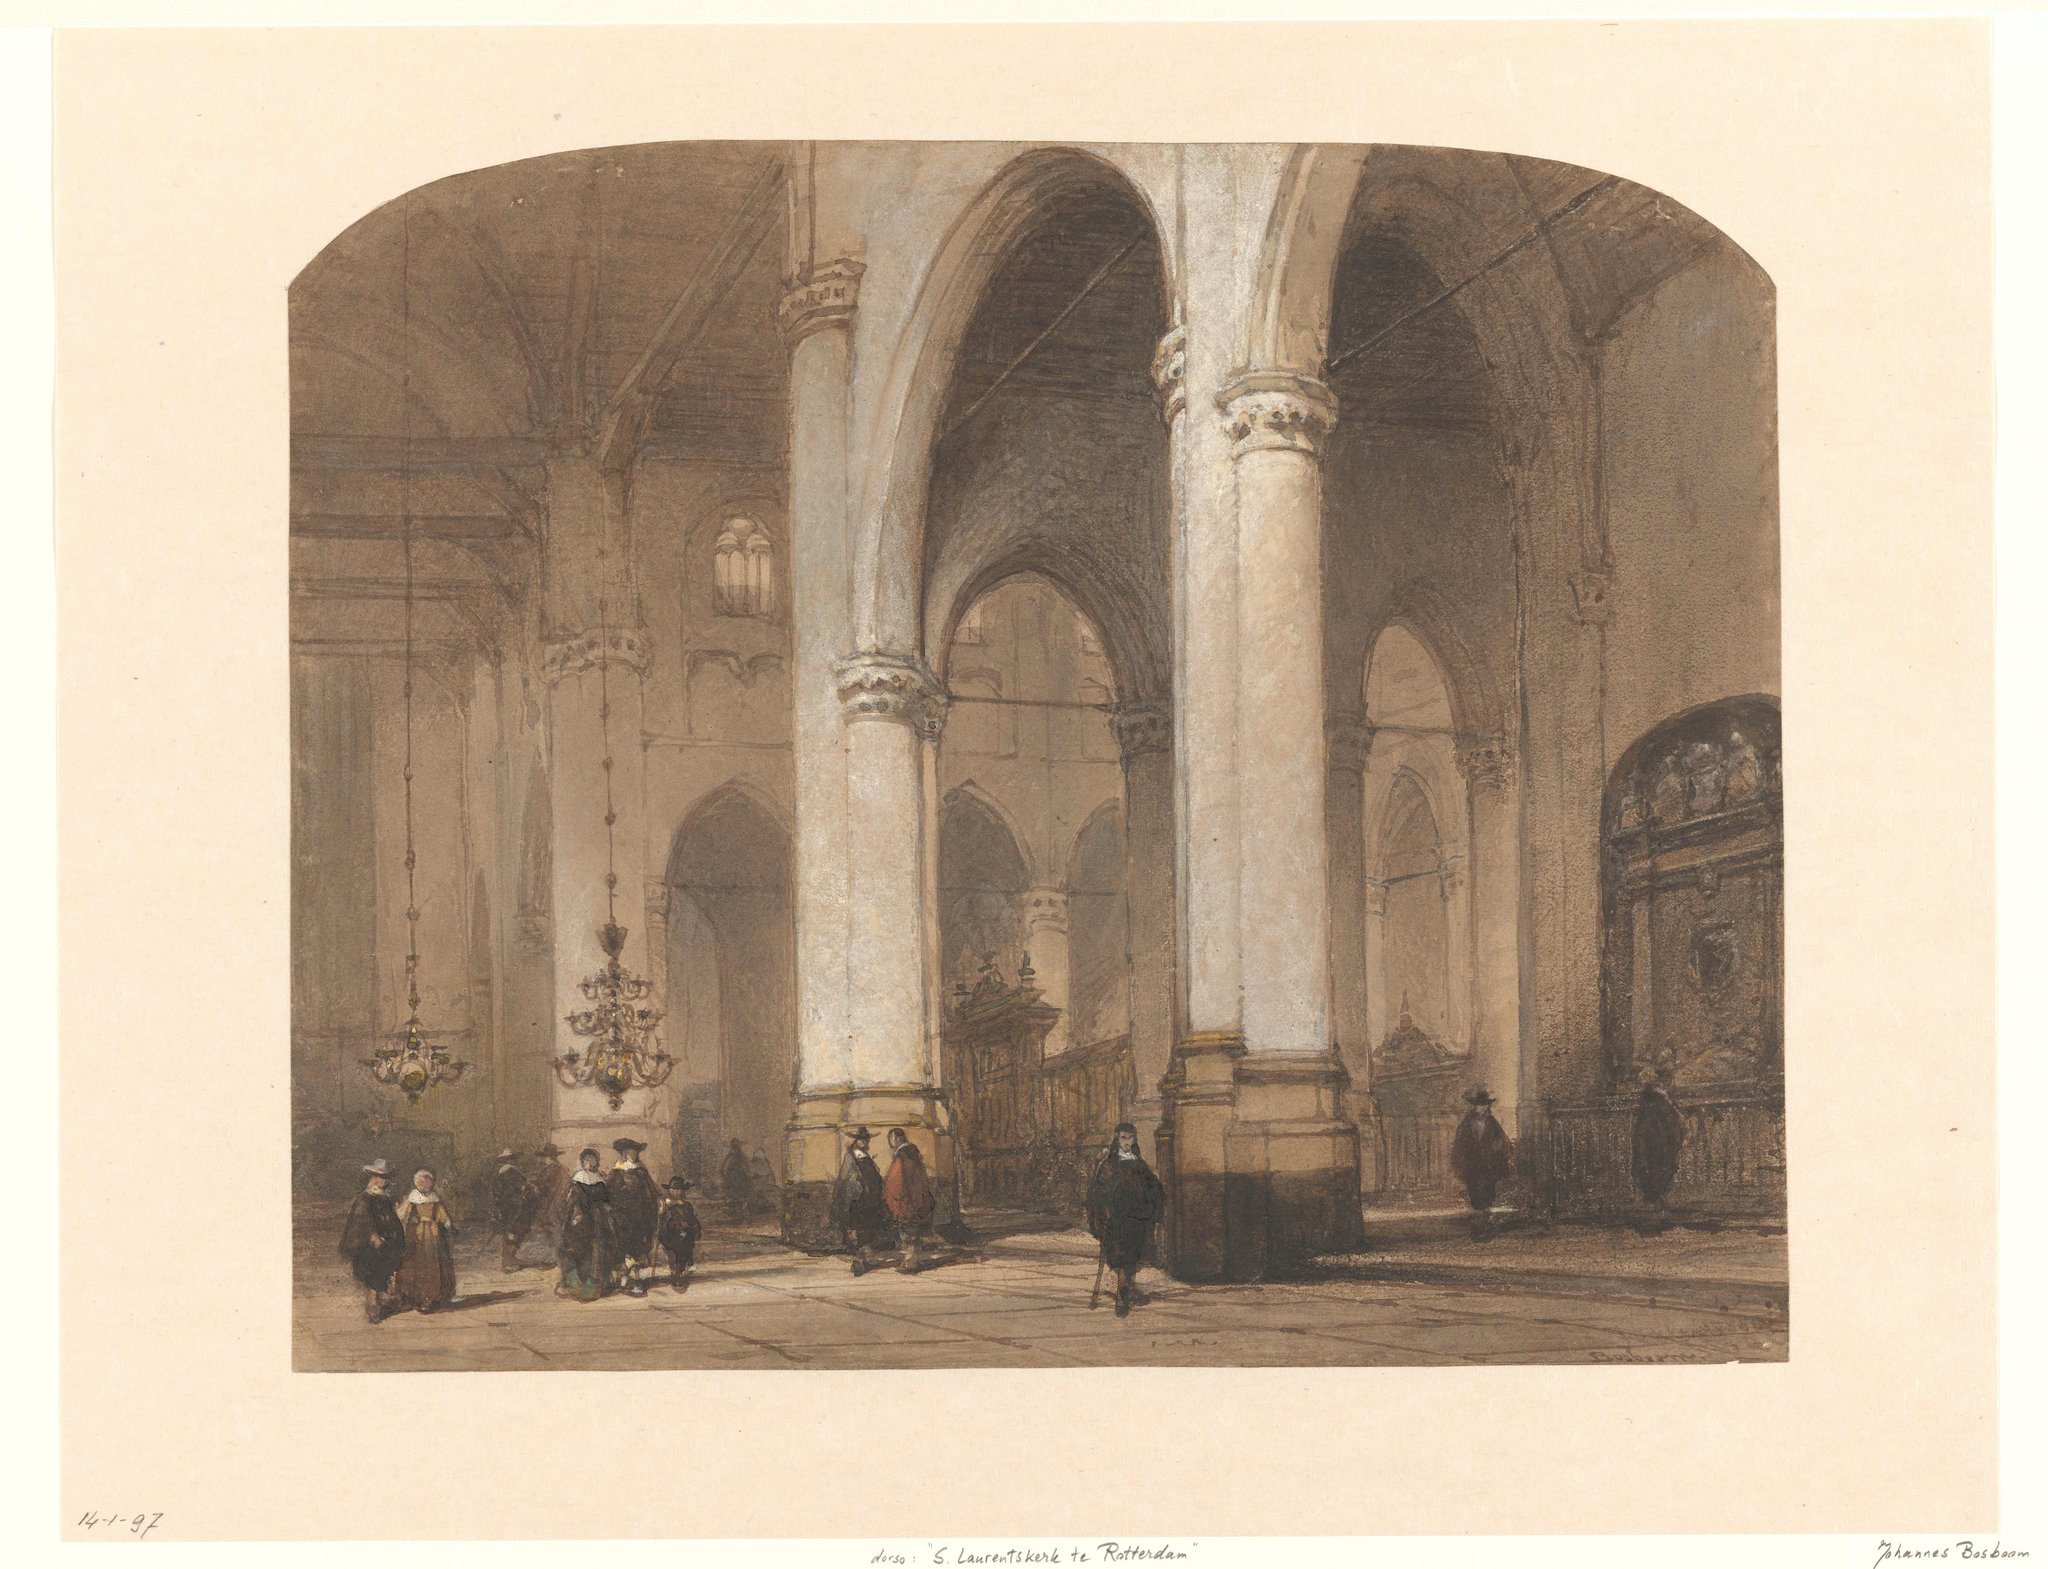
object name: watercolor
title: Gezicht in de St.-Laurenskerk te Rotterdam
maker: johannes bosboom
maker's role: draughtsman, painter, print maker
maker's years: 1817-1891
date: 1827-1891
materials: paint, ink, paper, watercolor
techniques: brush, pen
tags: interior of church, rotterdam